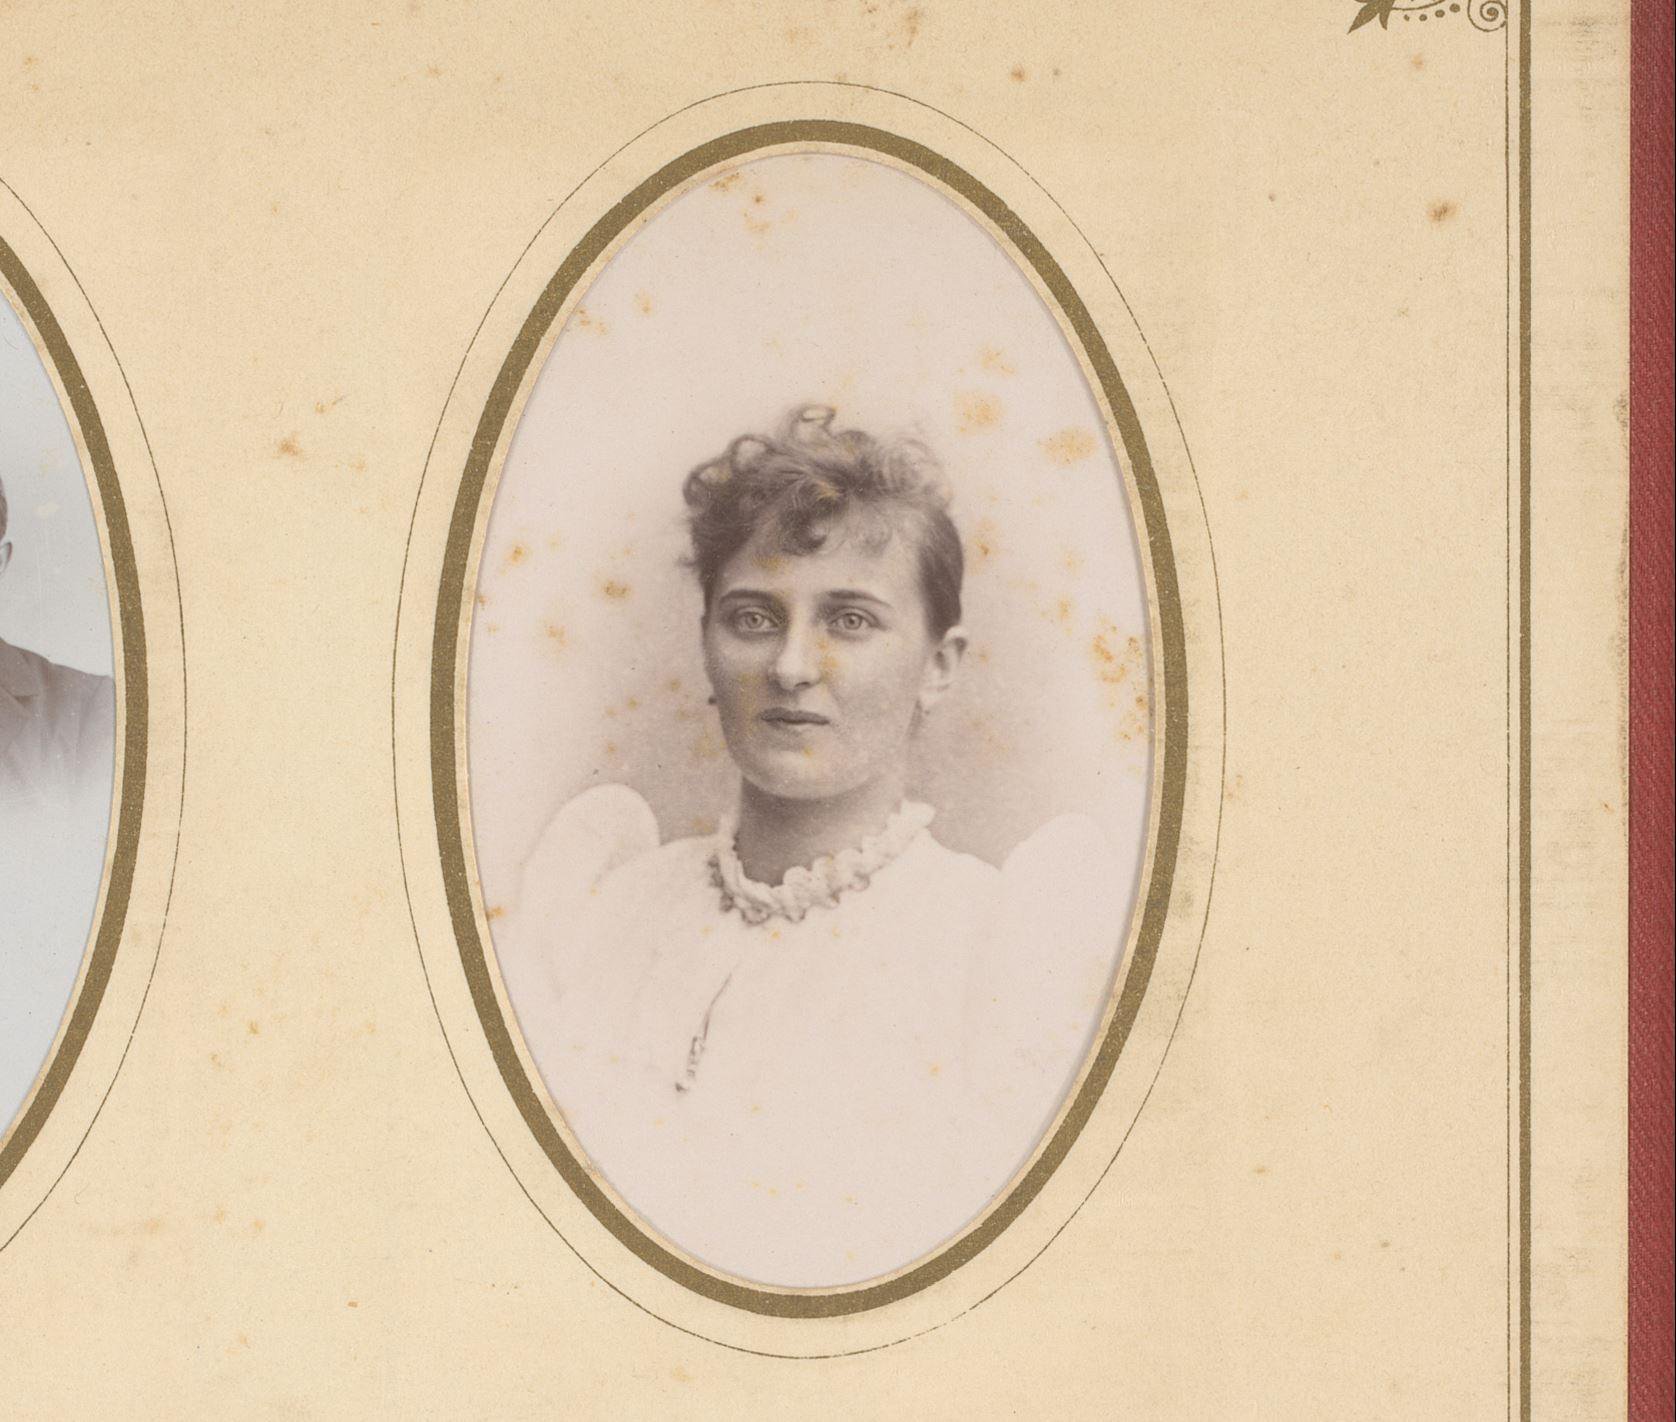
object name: carte de visite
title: Portret van een vrouw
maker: w. koolstra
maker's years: 1862-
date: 1888-1900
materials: cardboard, photographic support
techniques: albumen print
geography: groningen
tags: historical persons - bb - woman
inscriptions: inscription: ‘[W]. Koolstra/ Groningen/ Oosterstraat/ hoek Papengang D 20b’